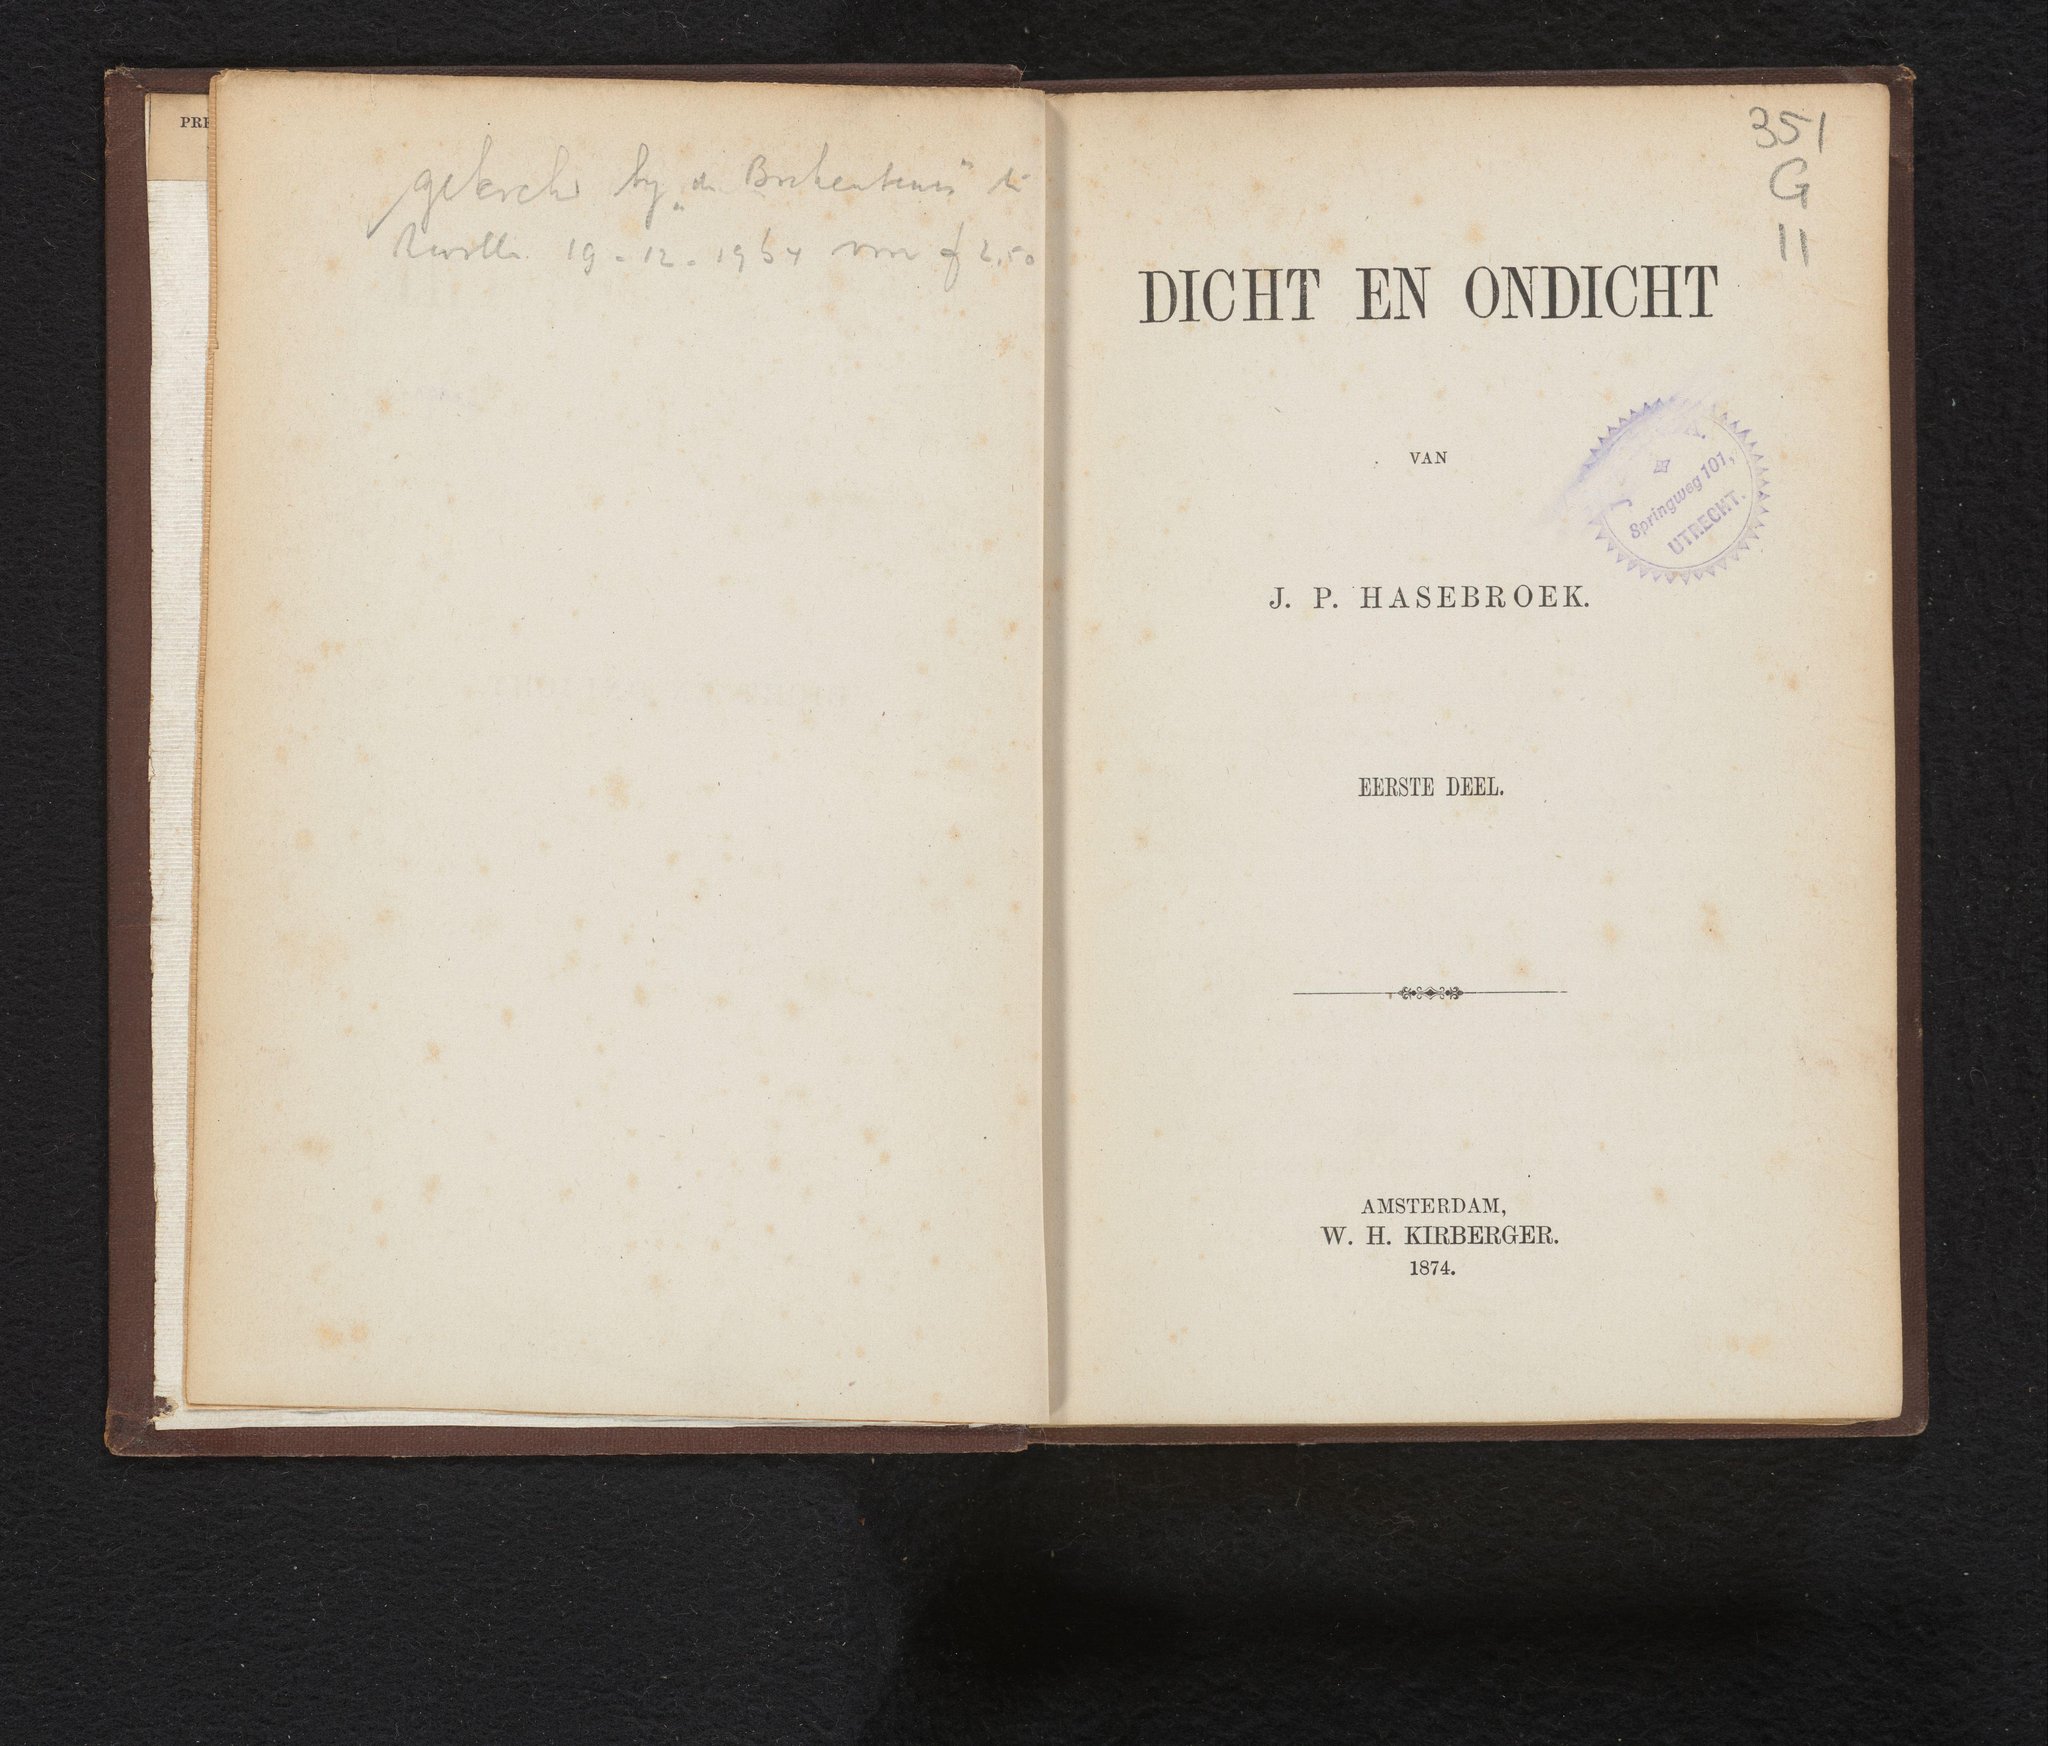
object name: book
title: Dicht en ondicht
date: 1874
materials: cardboard, linen, paper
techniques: albumen print, printing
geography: amsterdam